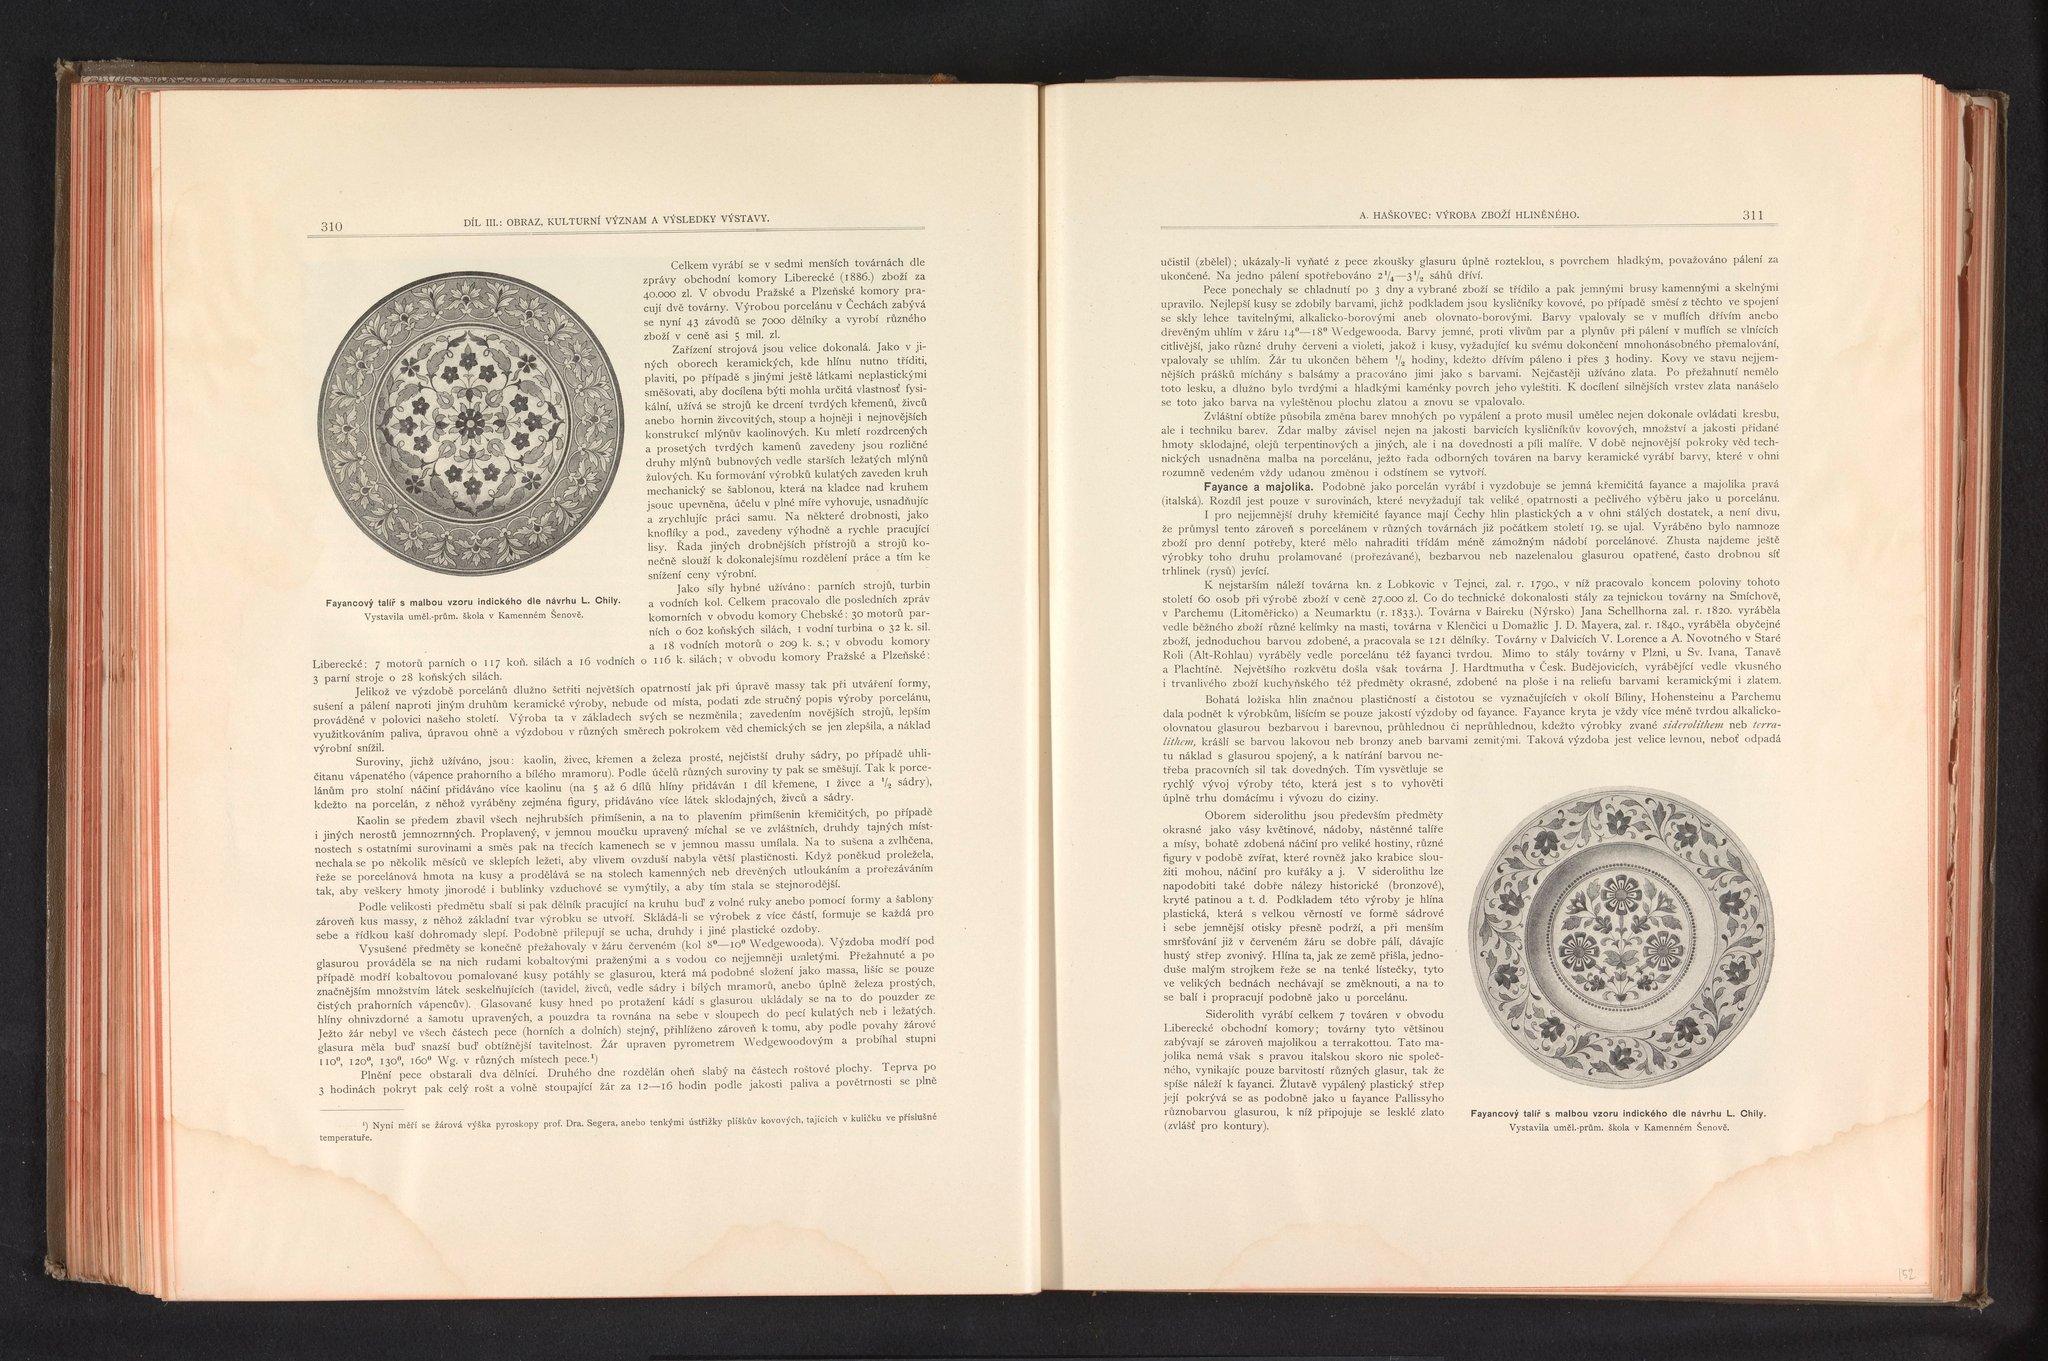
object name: page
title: Fayancový talir s malbou vzoru indického dle návrhu L. Chily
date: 1890-1895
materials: paper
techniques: autotype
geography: prague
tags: dish, plate, saucer